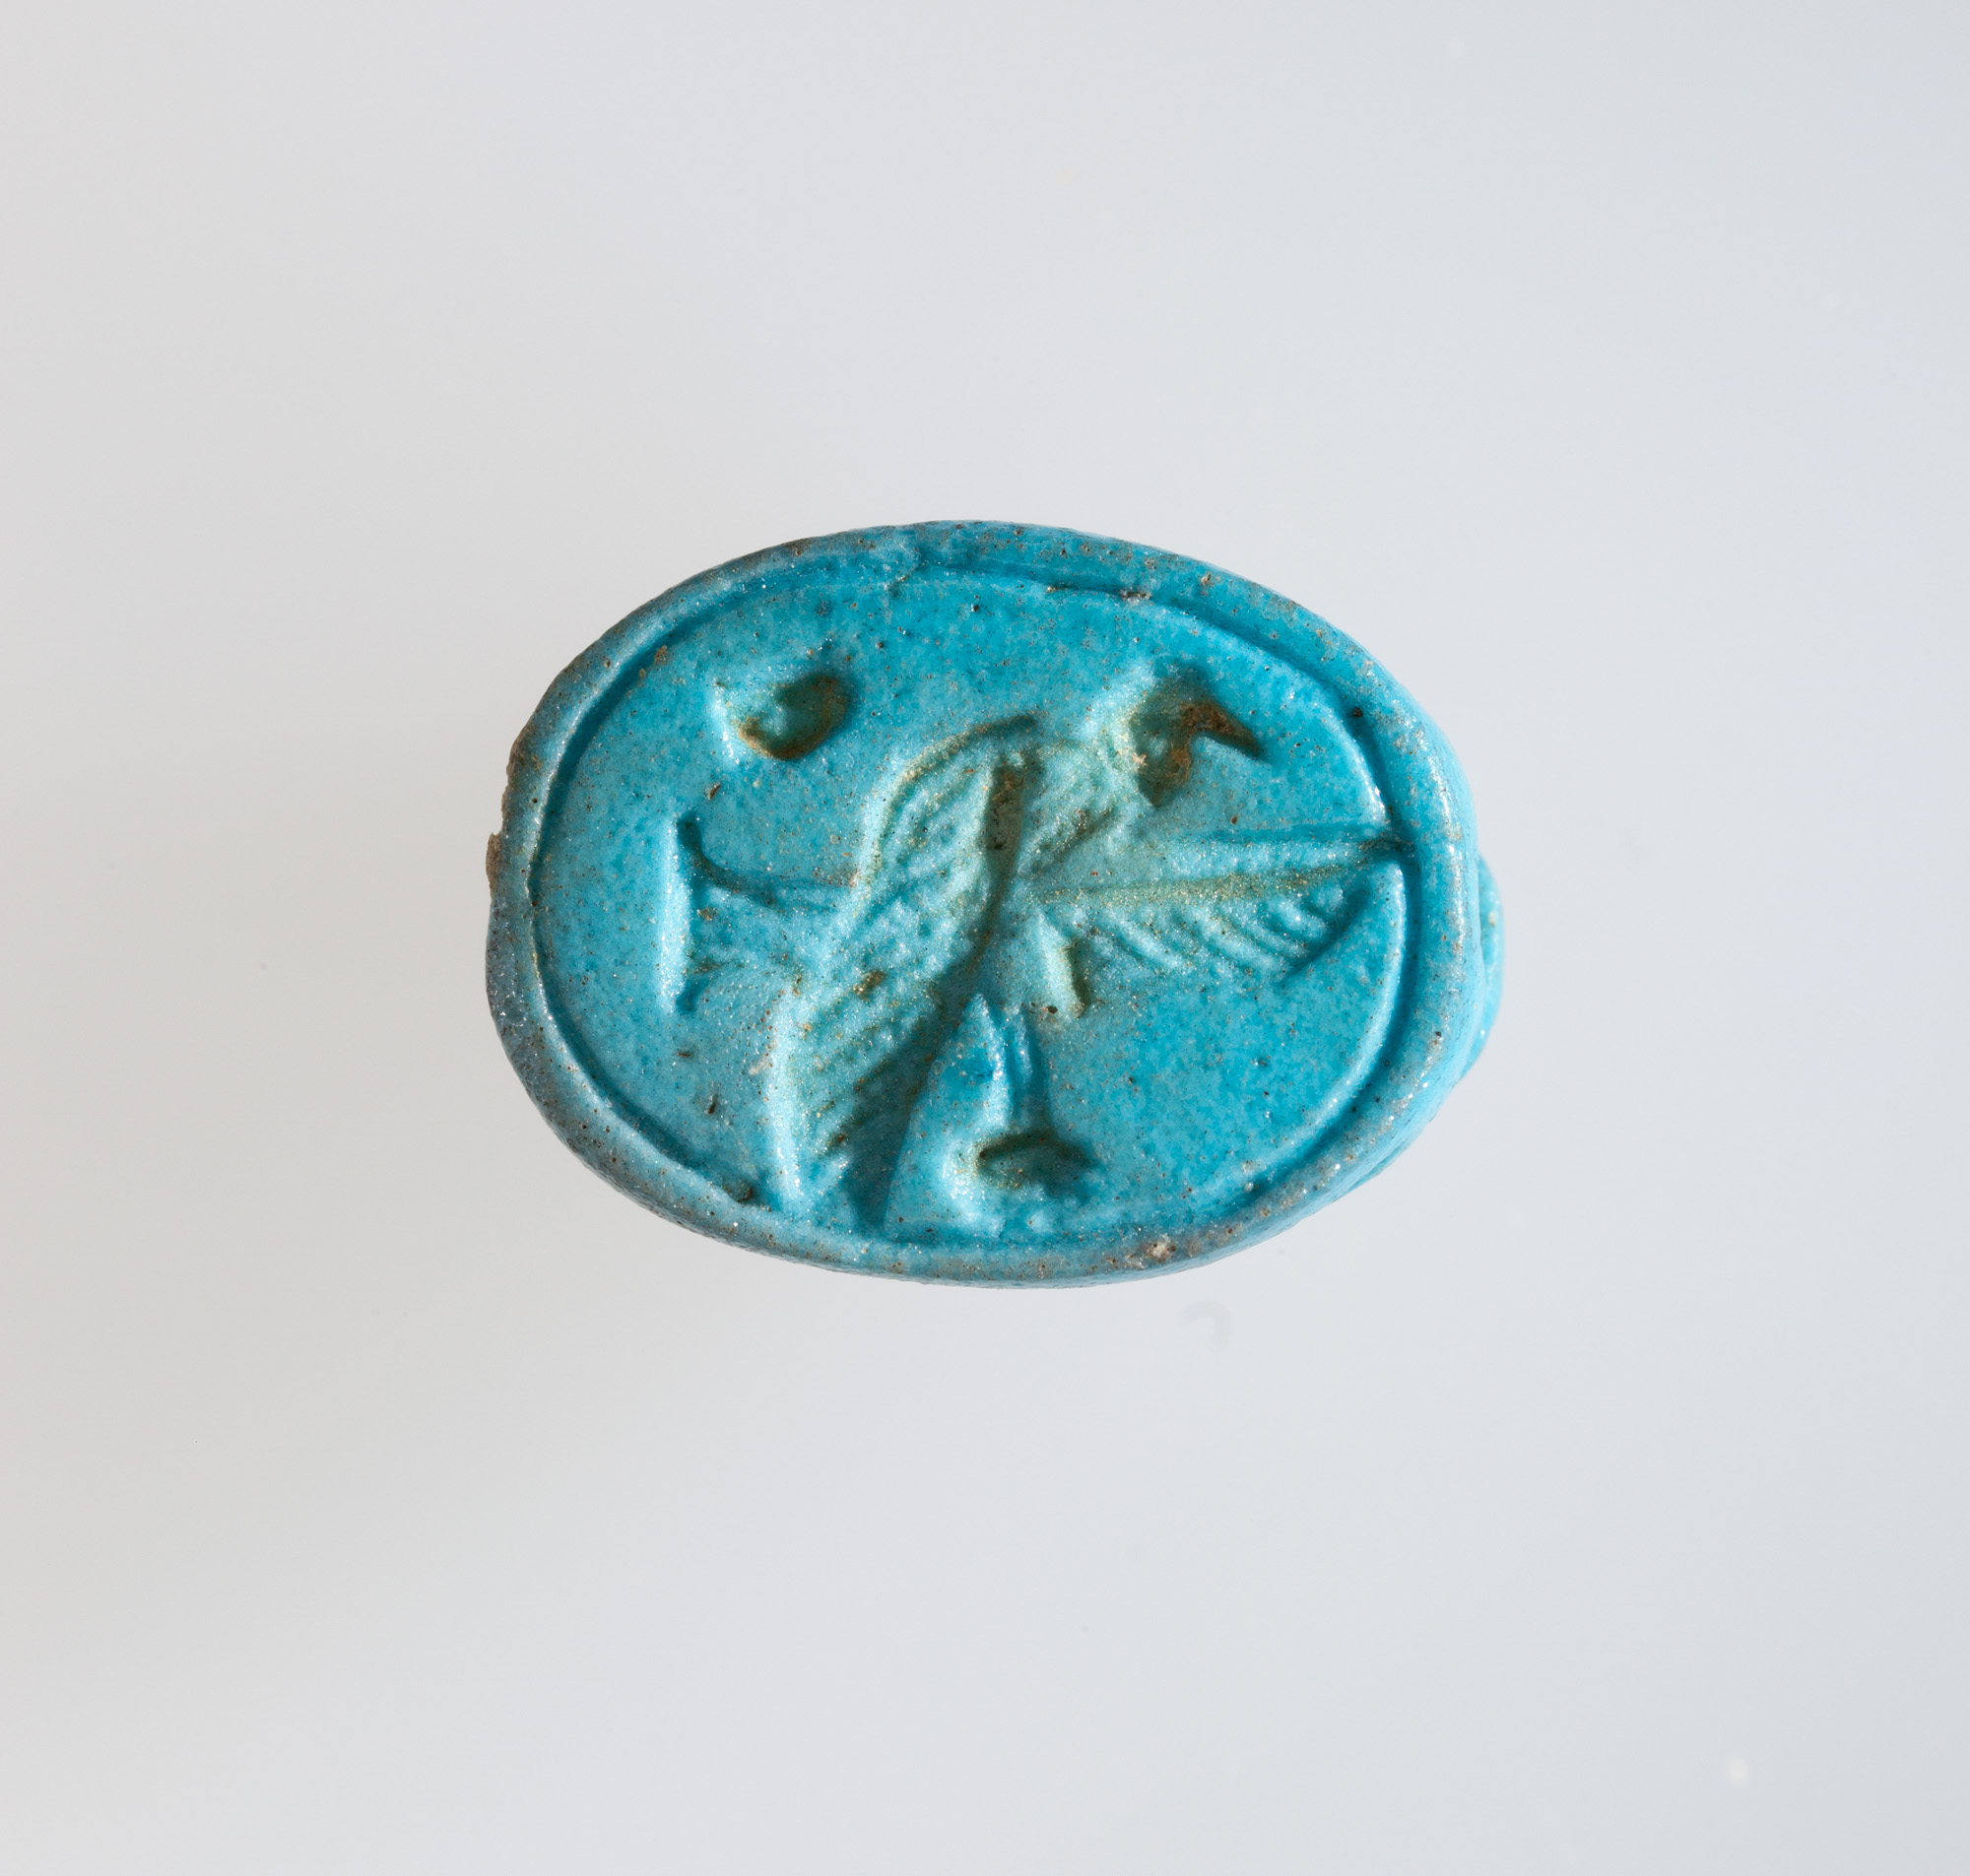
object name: scarab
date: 1479-1458 BCE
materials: faience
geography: egypt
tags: birds,scarabs